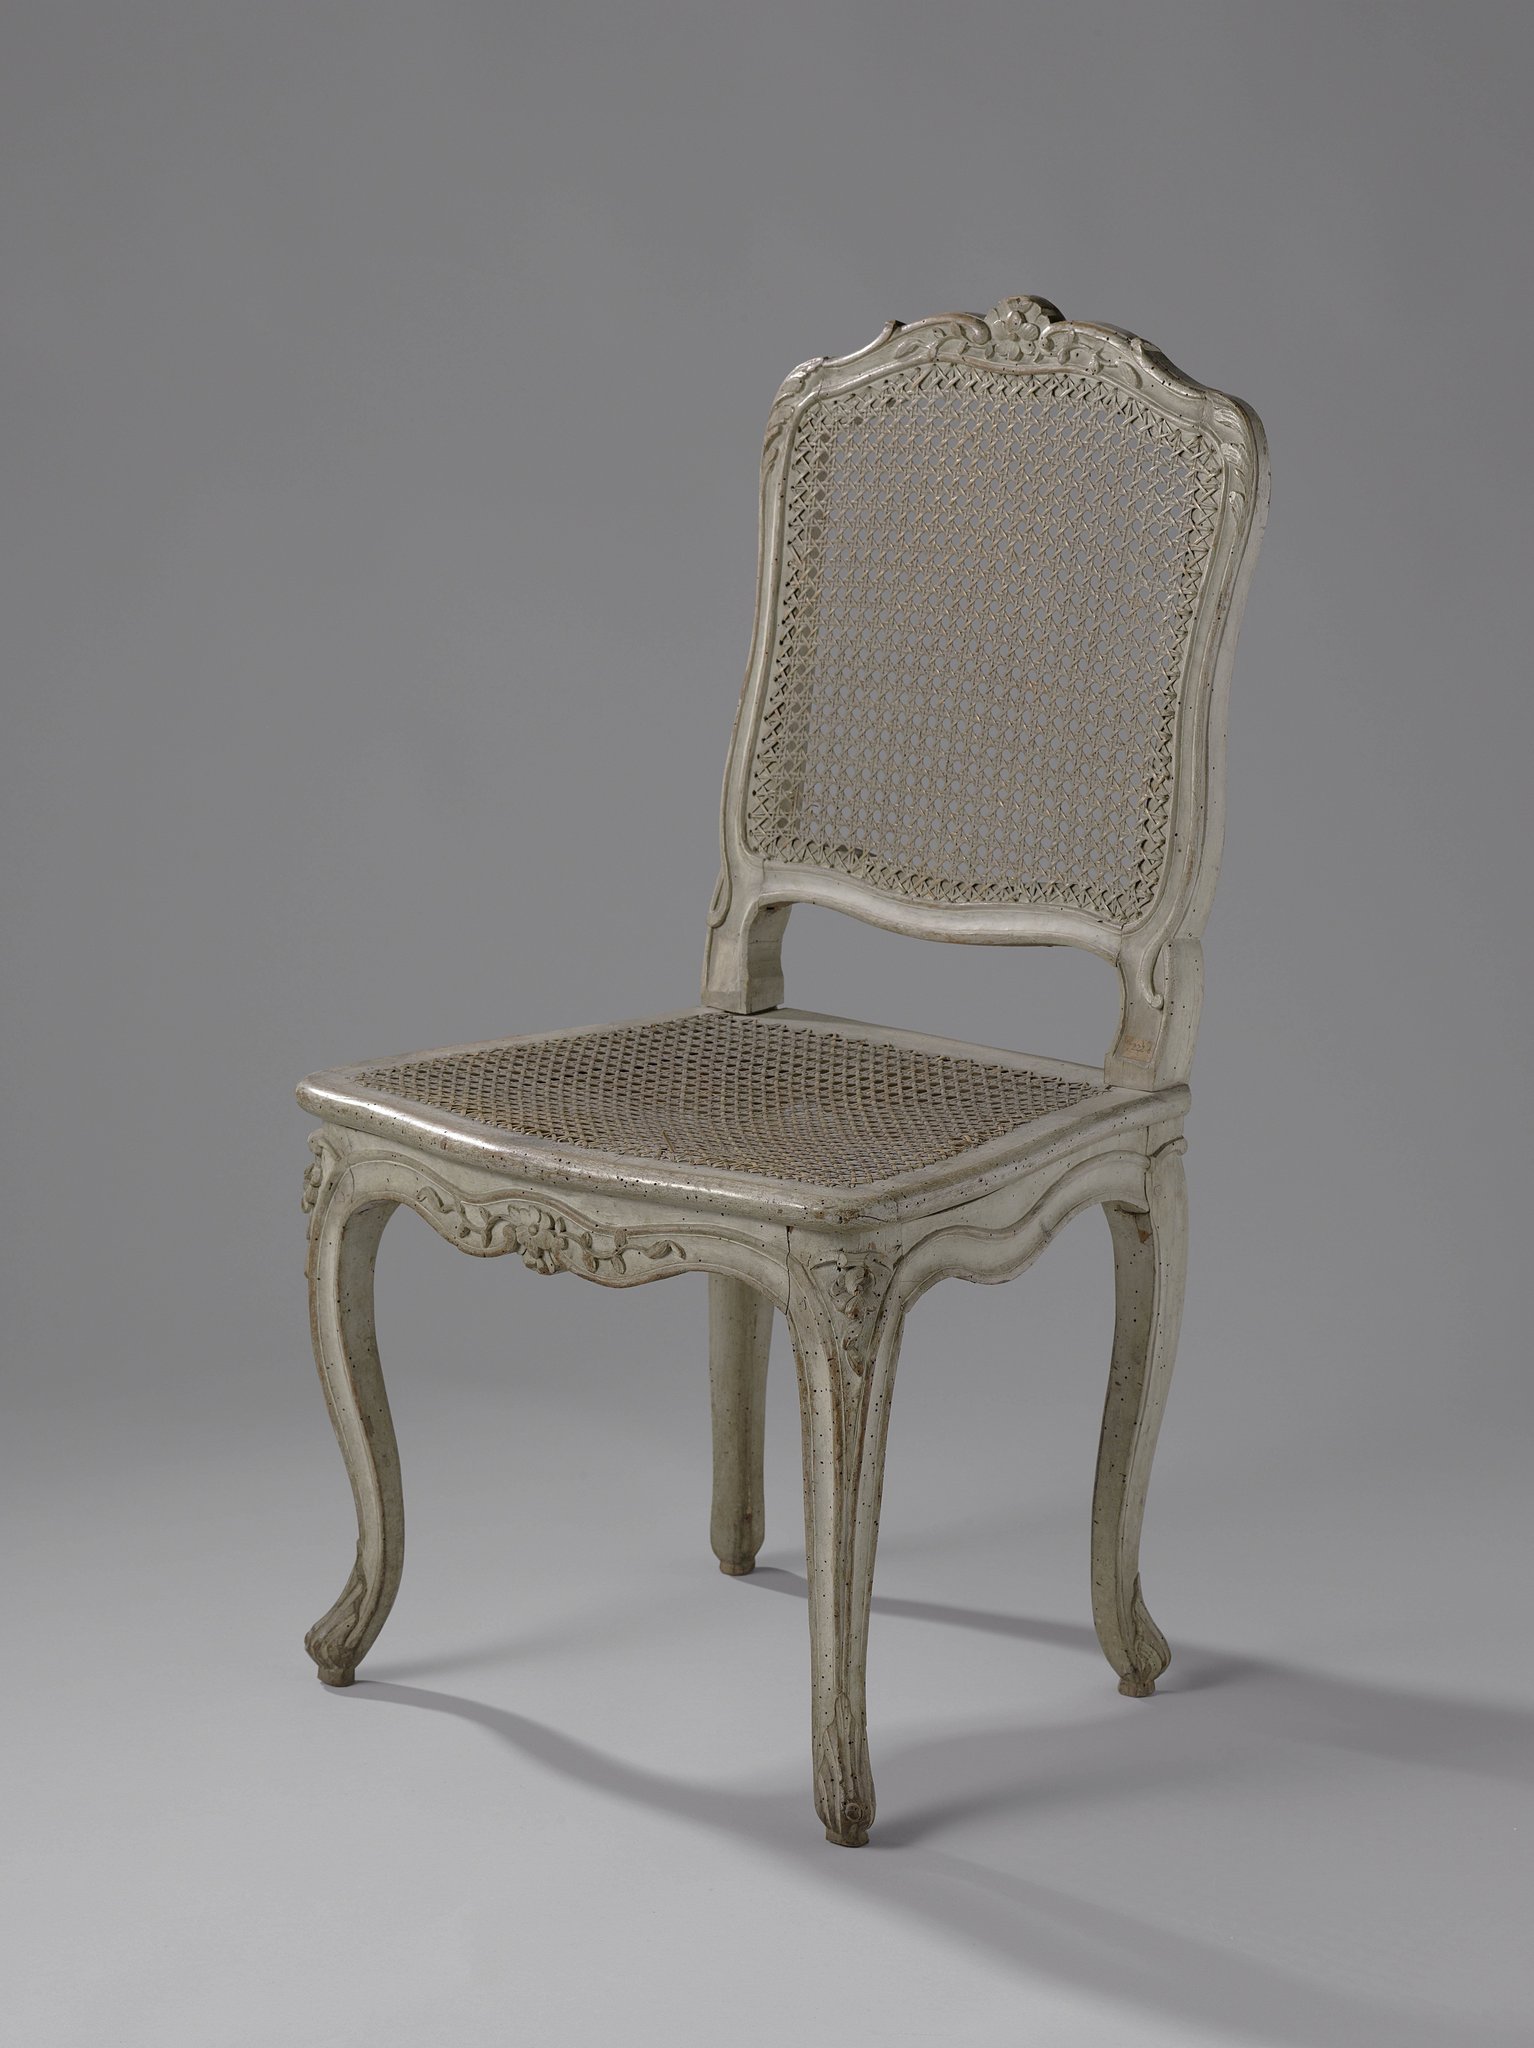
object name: chair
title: Stoel van witgeschilderd beukenhout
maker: noël poirié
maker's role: furniture worker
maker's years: -1753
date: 1740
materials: wood, paint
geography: france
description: Stoel van witgeschilderd beukenhout, met riet bespannen. De overhoeks geplaatste S-vormige poten eindigen in een acanthusblad en gaan in de zitregels over. Op de zwellingen der voorpoten, het midden van de voorzitregel en de bovendorpel van het rugraam zijn bloemtakjes aangebracht. Het zitraam, met licht geschulpte voorkant en gewelfde zijkanten, steekt over en is trapeziumvormig. Het gestutte rugraam heeft gestrekt S-vormige stijlen met kleine voluten boven en acanthusblad onder en geschulpte dorpels.